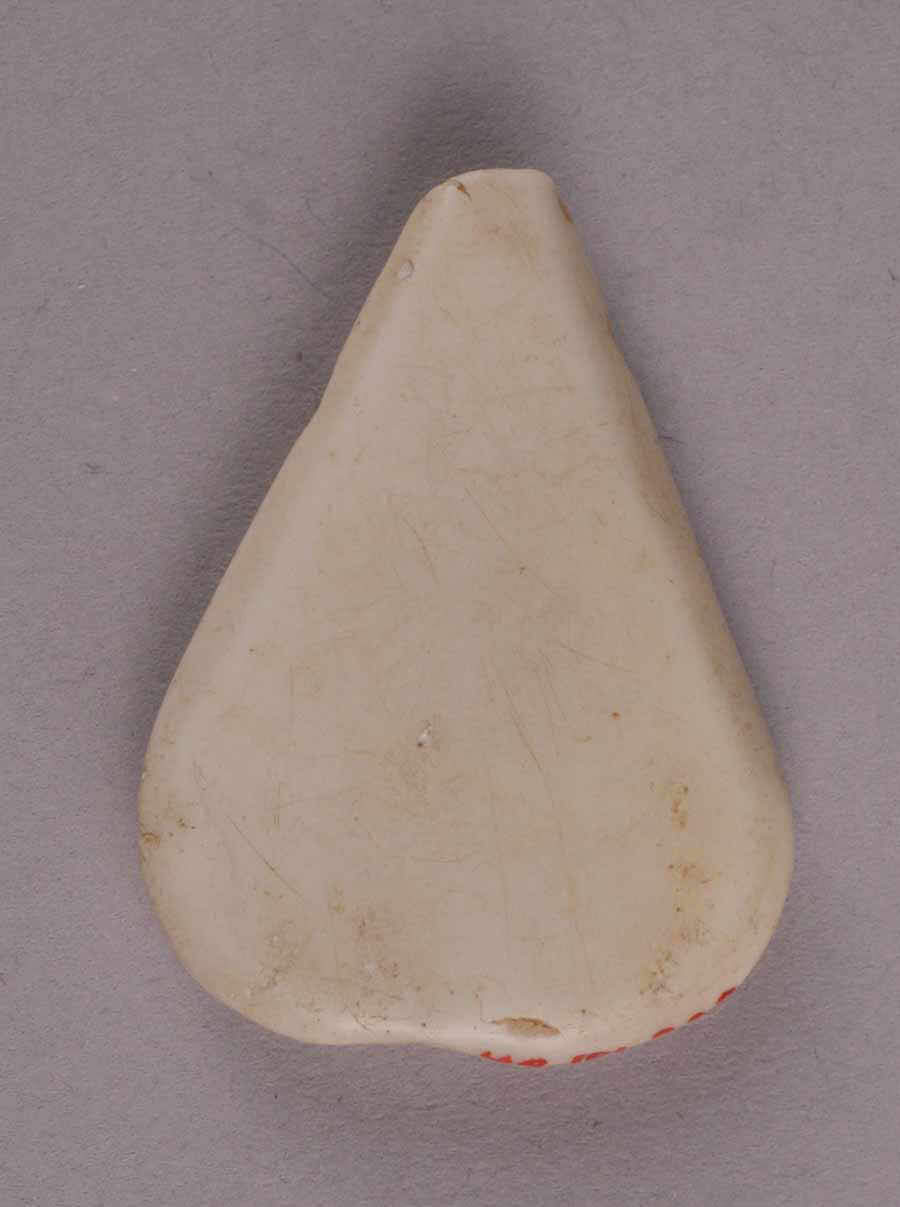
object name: bead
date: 801-1000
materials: bone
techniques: carving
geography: iran